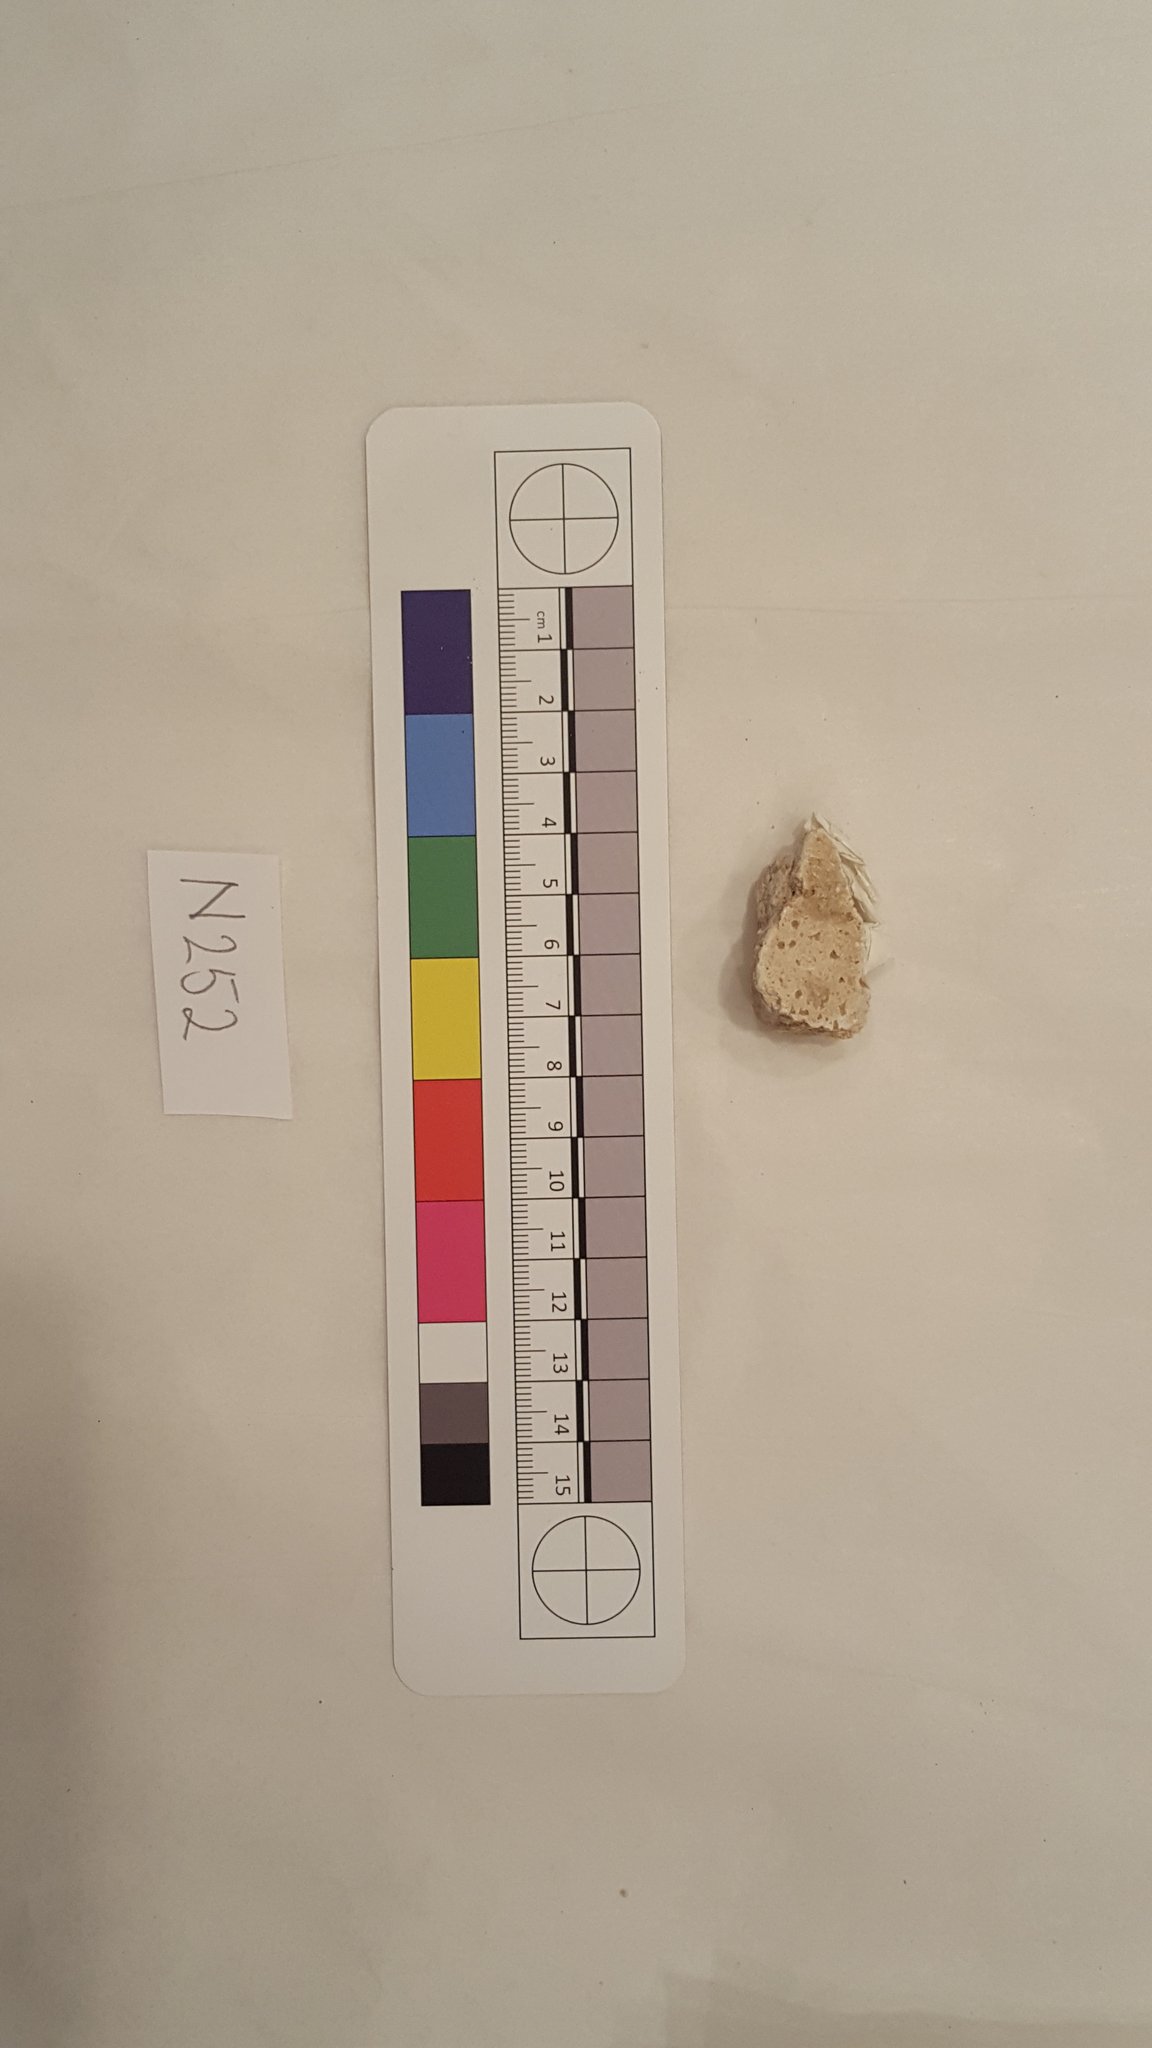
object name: fragment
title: Stucco Fragment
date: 701-1200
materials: plaster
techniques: carving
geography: iran